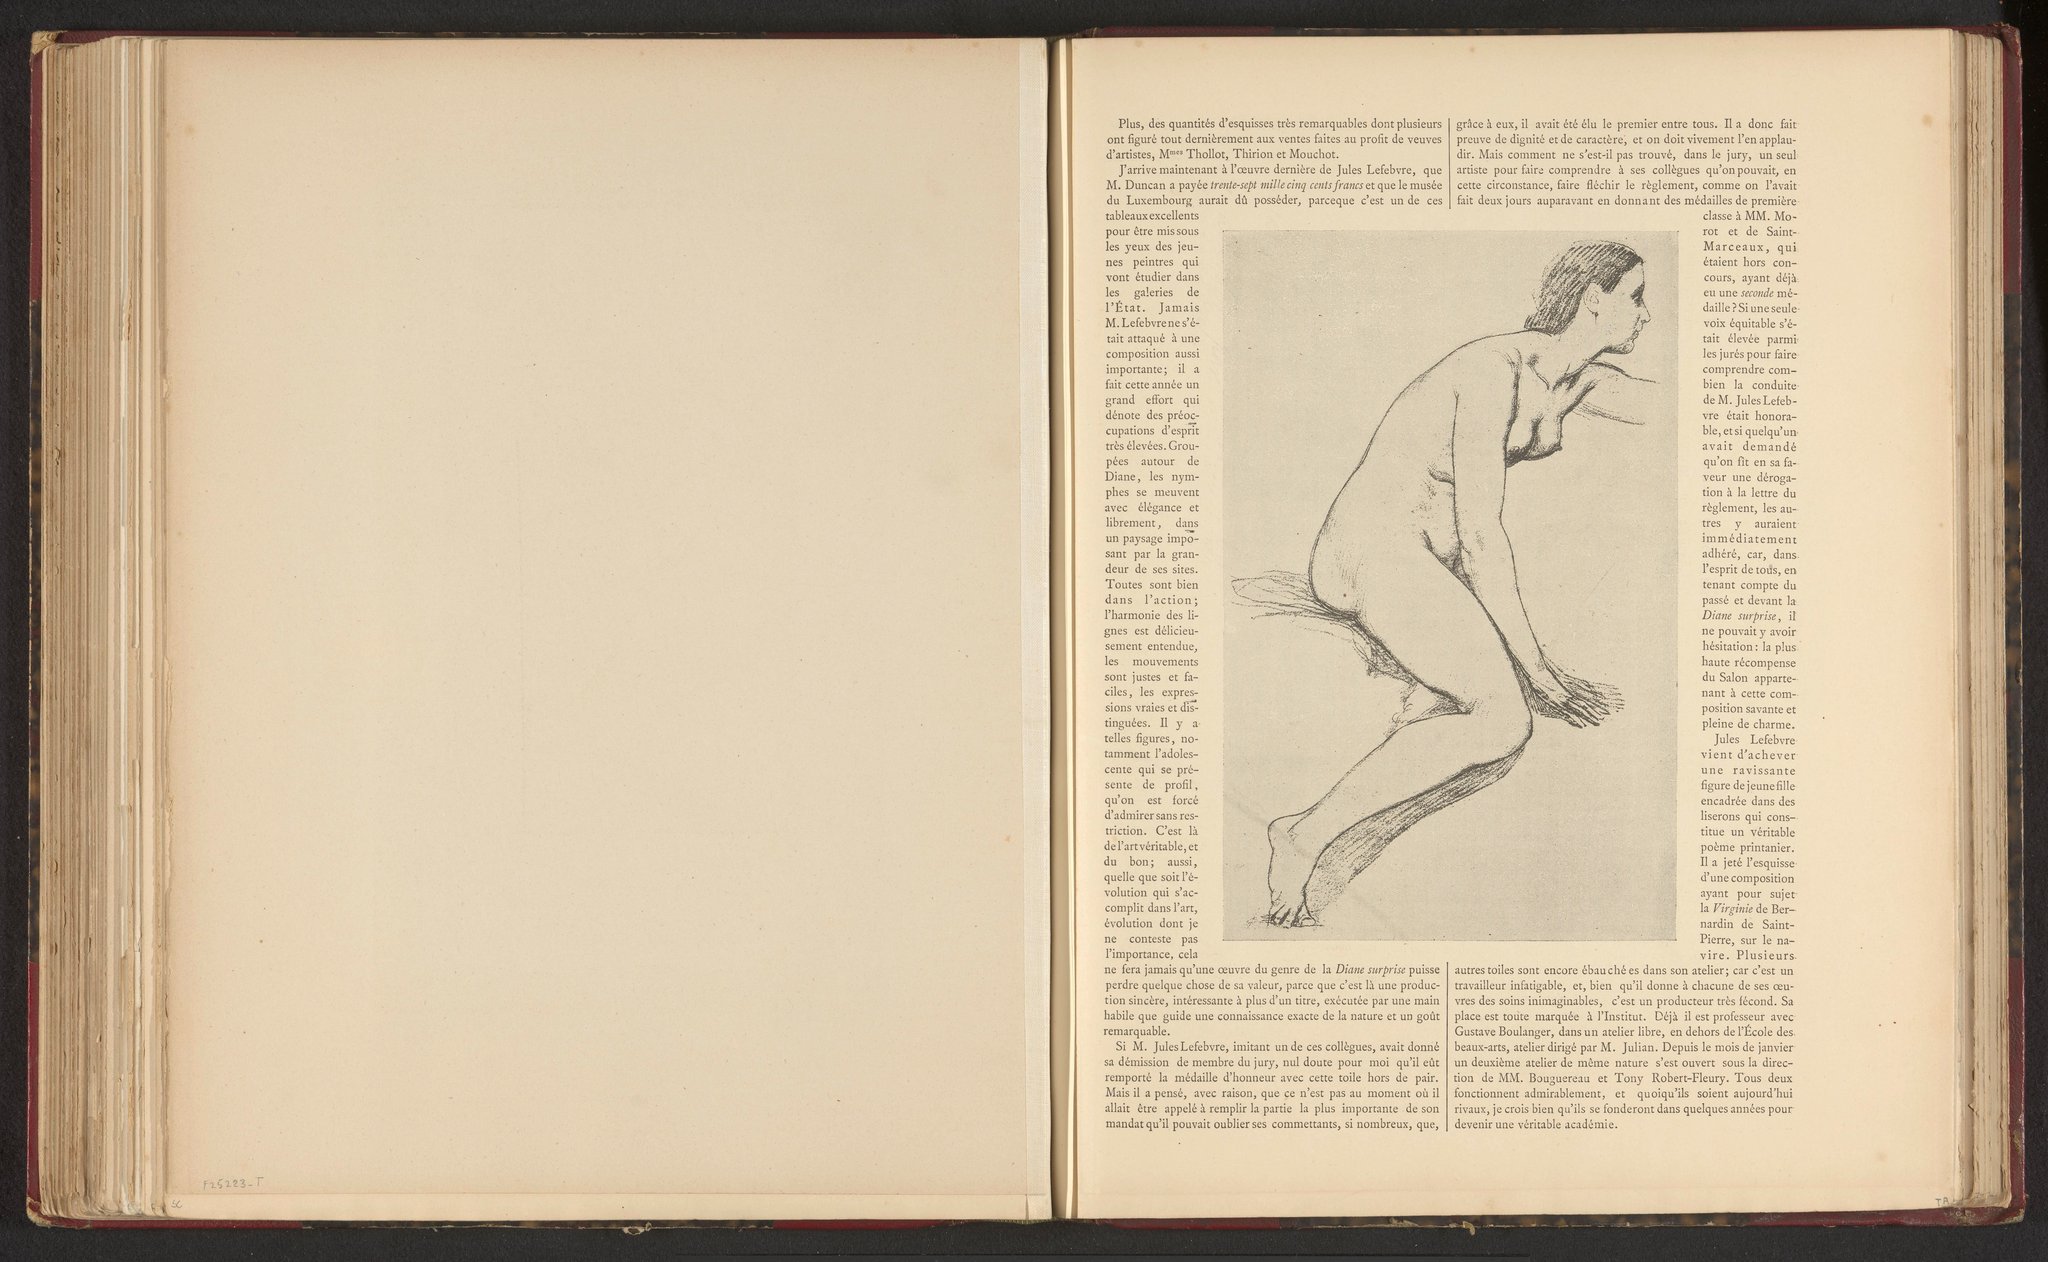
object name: page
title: Fotoreproductie van een tekening door vermoedelijk Jules Joseph Lefebvre, voorstellend een vrouwelijk naakt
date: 1876-1879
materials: paper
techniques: autotype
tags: drawing, sketch, the (nude) human figure; 'corpo humano' (ripa) - aa - female human figure